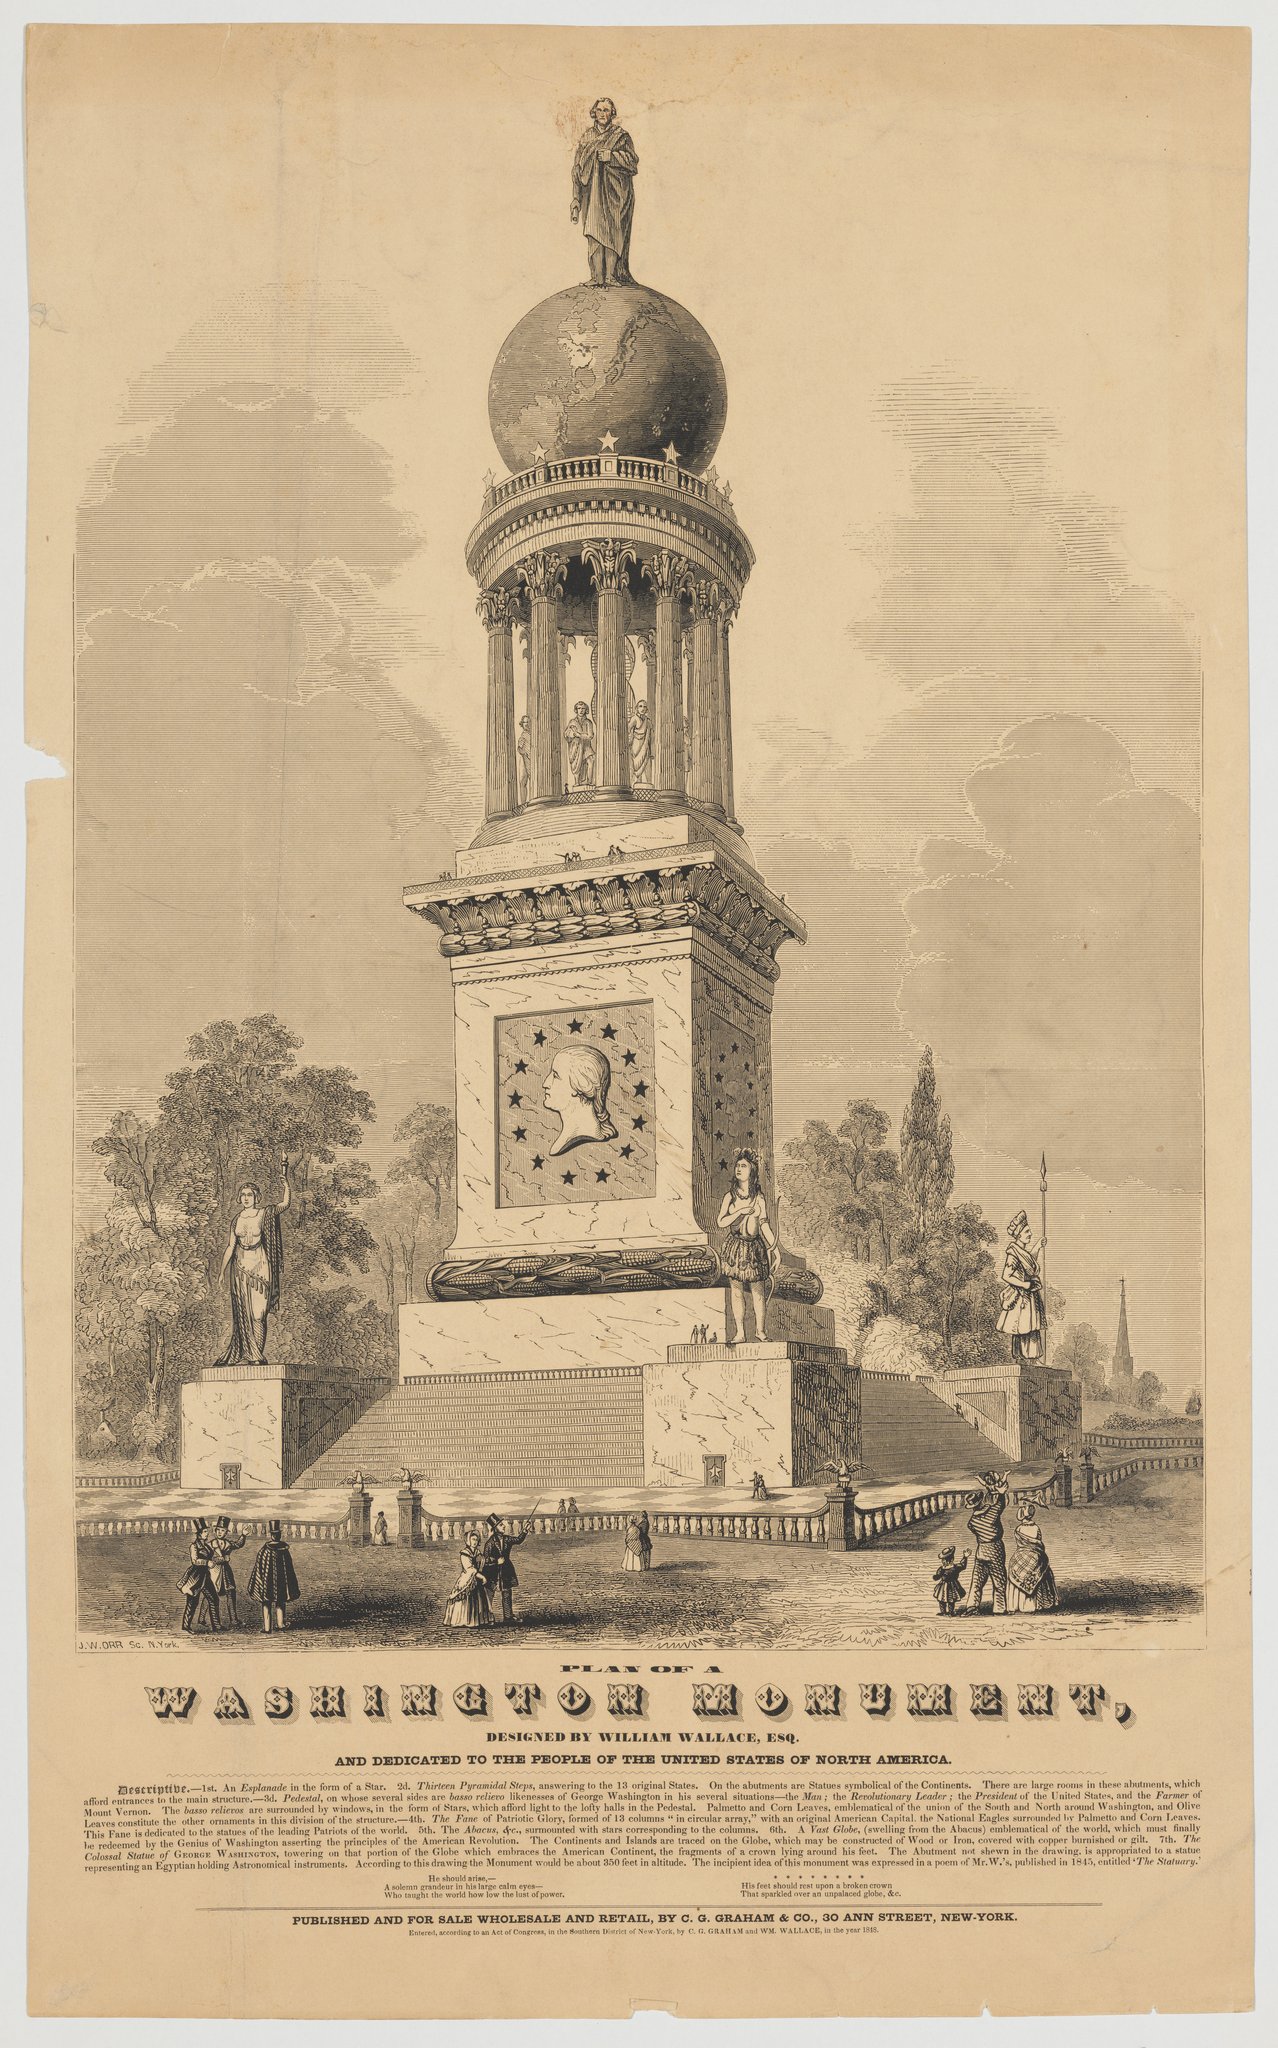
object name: print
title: Plan of a Washington Monument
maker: john william orr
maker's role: artist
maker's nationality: american, born ireland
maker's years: 1815-1887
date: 1848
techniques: engraving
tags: monuments,george washington